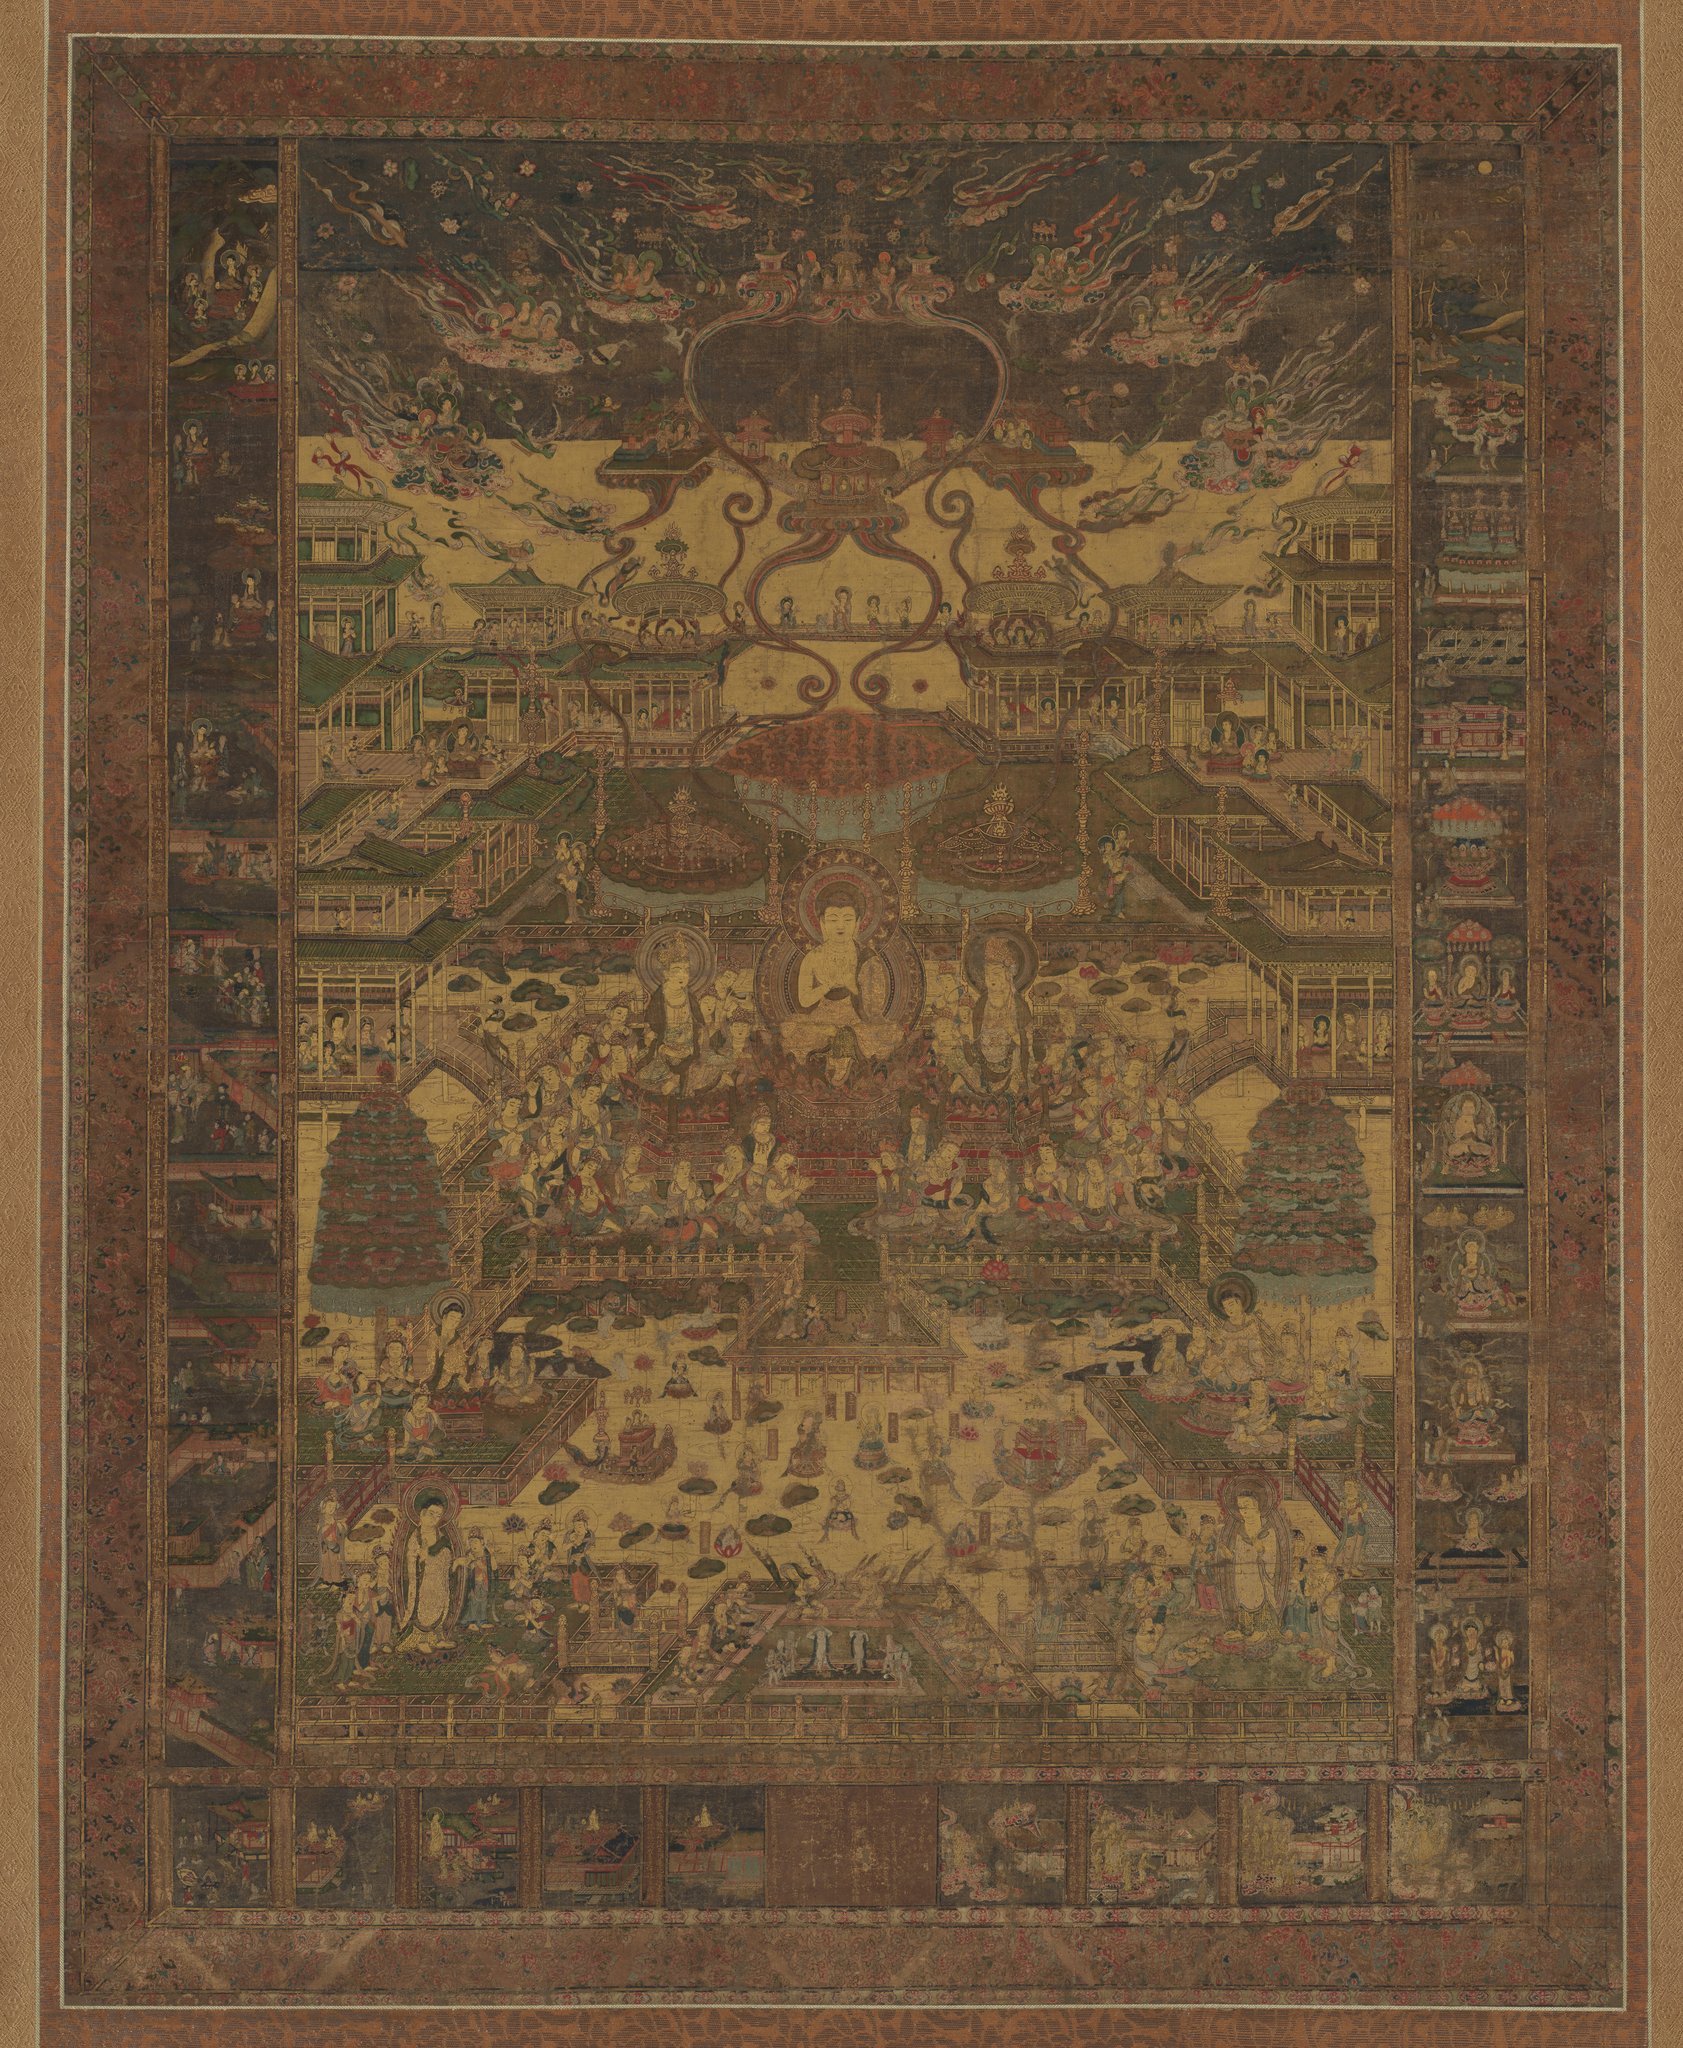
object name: hanging scroll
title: Taima Mandala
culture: japanese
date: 1301-1400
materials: gold, ink, silk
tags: palaces,buddhism,bodhisattvas,buddha,dancers,musicians